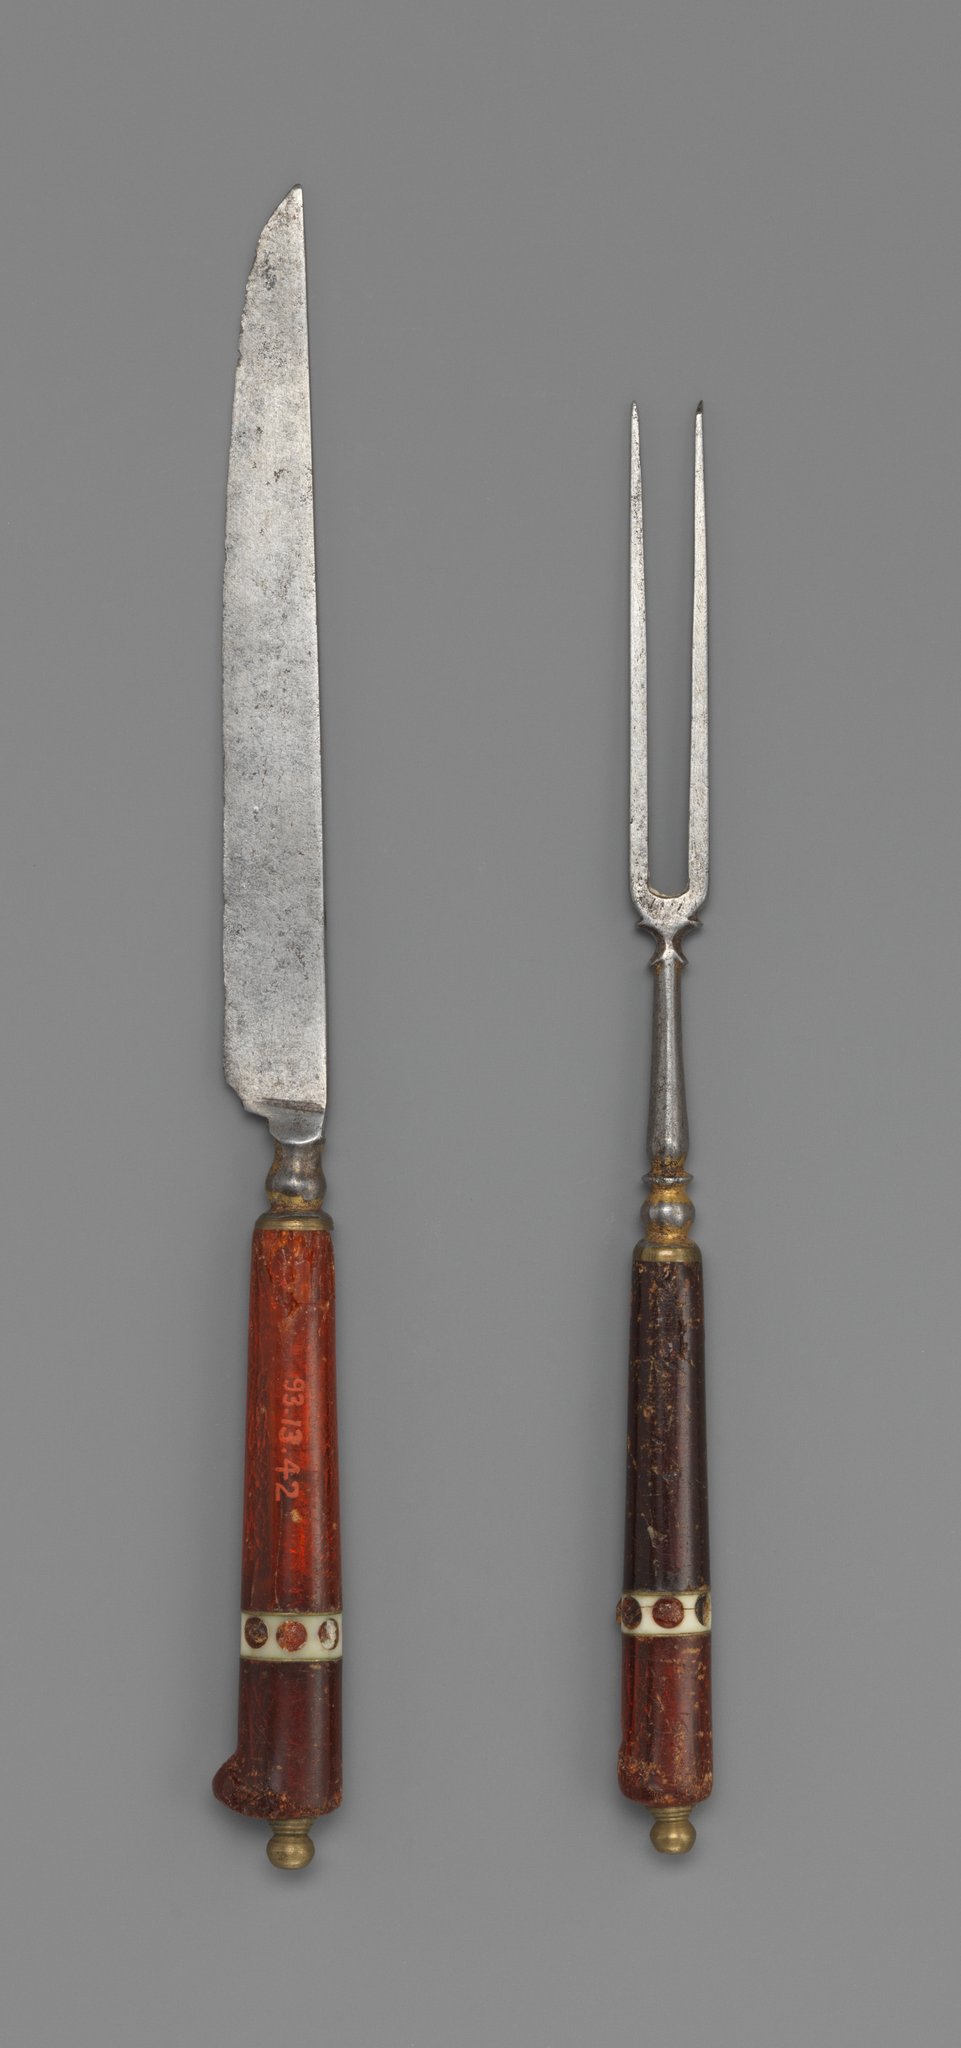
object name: table fork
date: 1601-1700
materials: amber, brass, steel